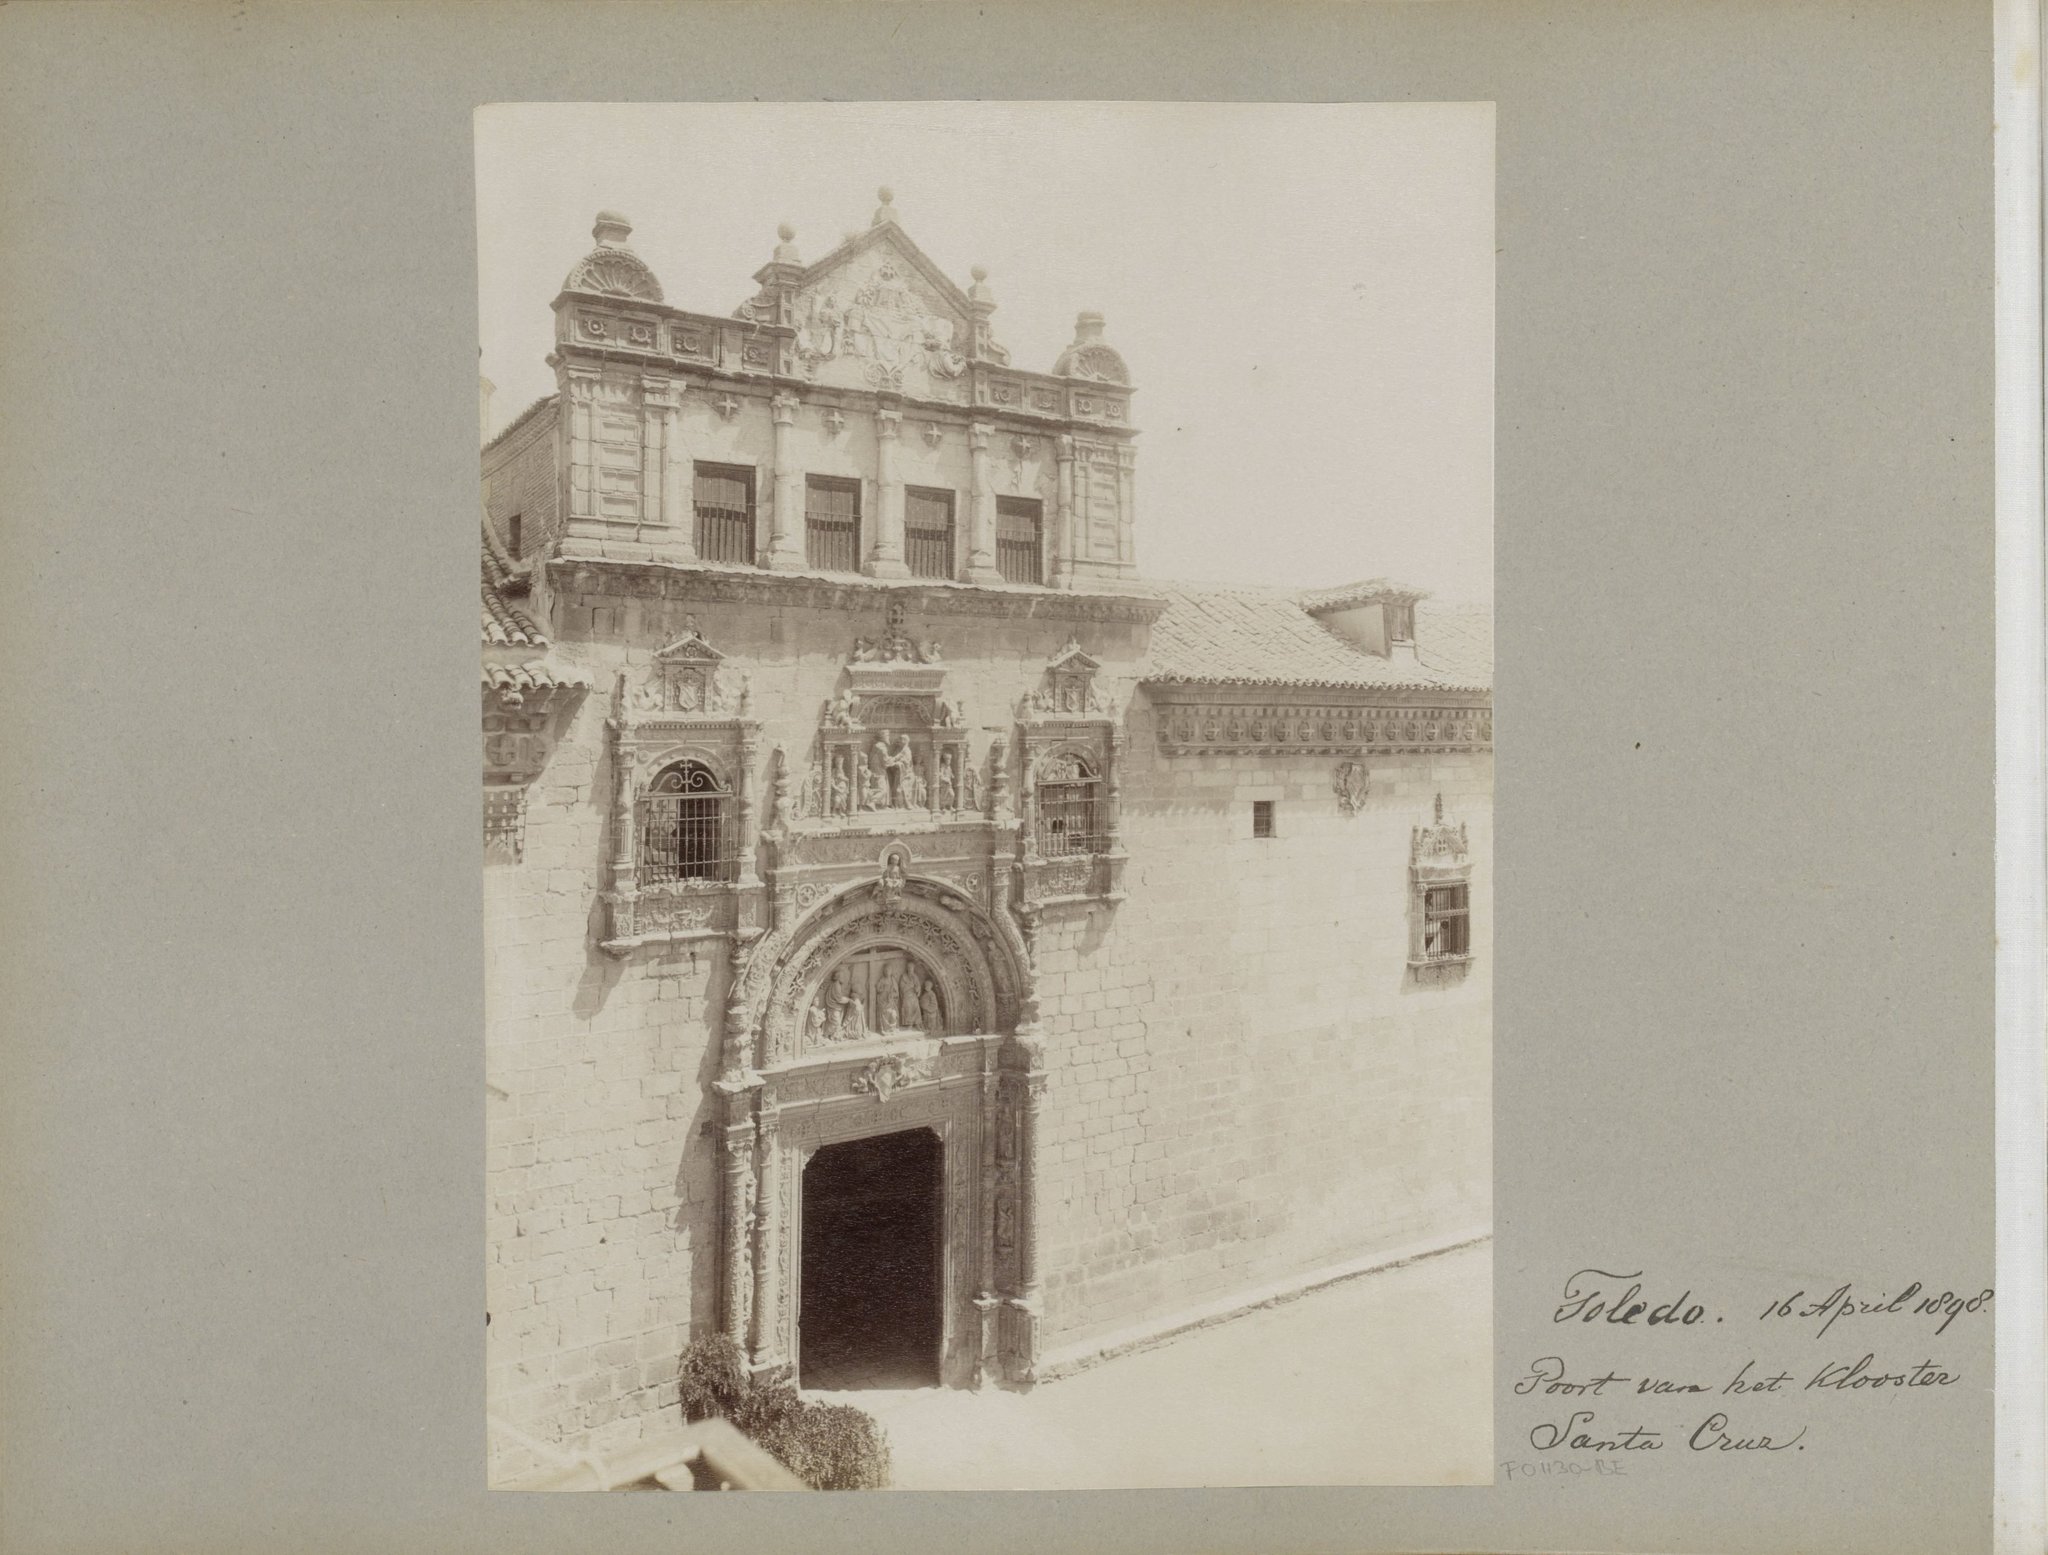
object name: album leaf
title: Poort van het klooster Santa Cruz in Toledo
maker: Anonymous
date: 1880-1898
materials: paper, photographic support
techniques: albumen print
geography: toledo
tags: abbey, monastery, convent ~ roman catholic church, gate, entrance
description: Onderdeel van Reisalbum met foto's van bezienswaardigheden in Frankrijk, Spanje, Italië, Duitsland, Zwitserland en Oostenrijk.